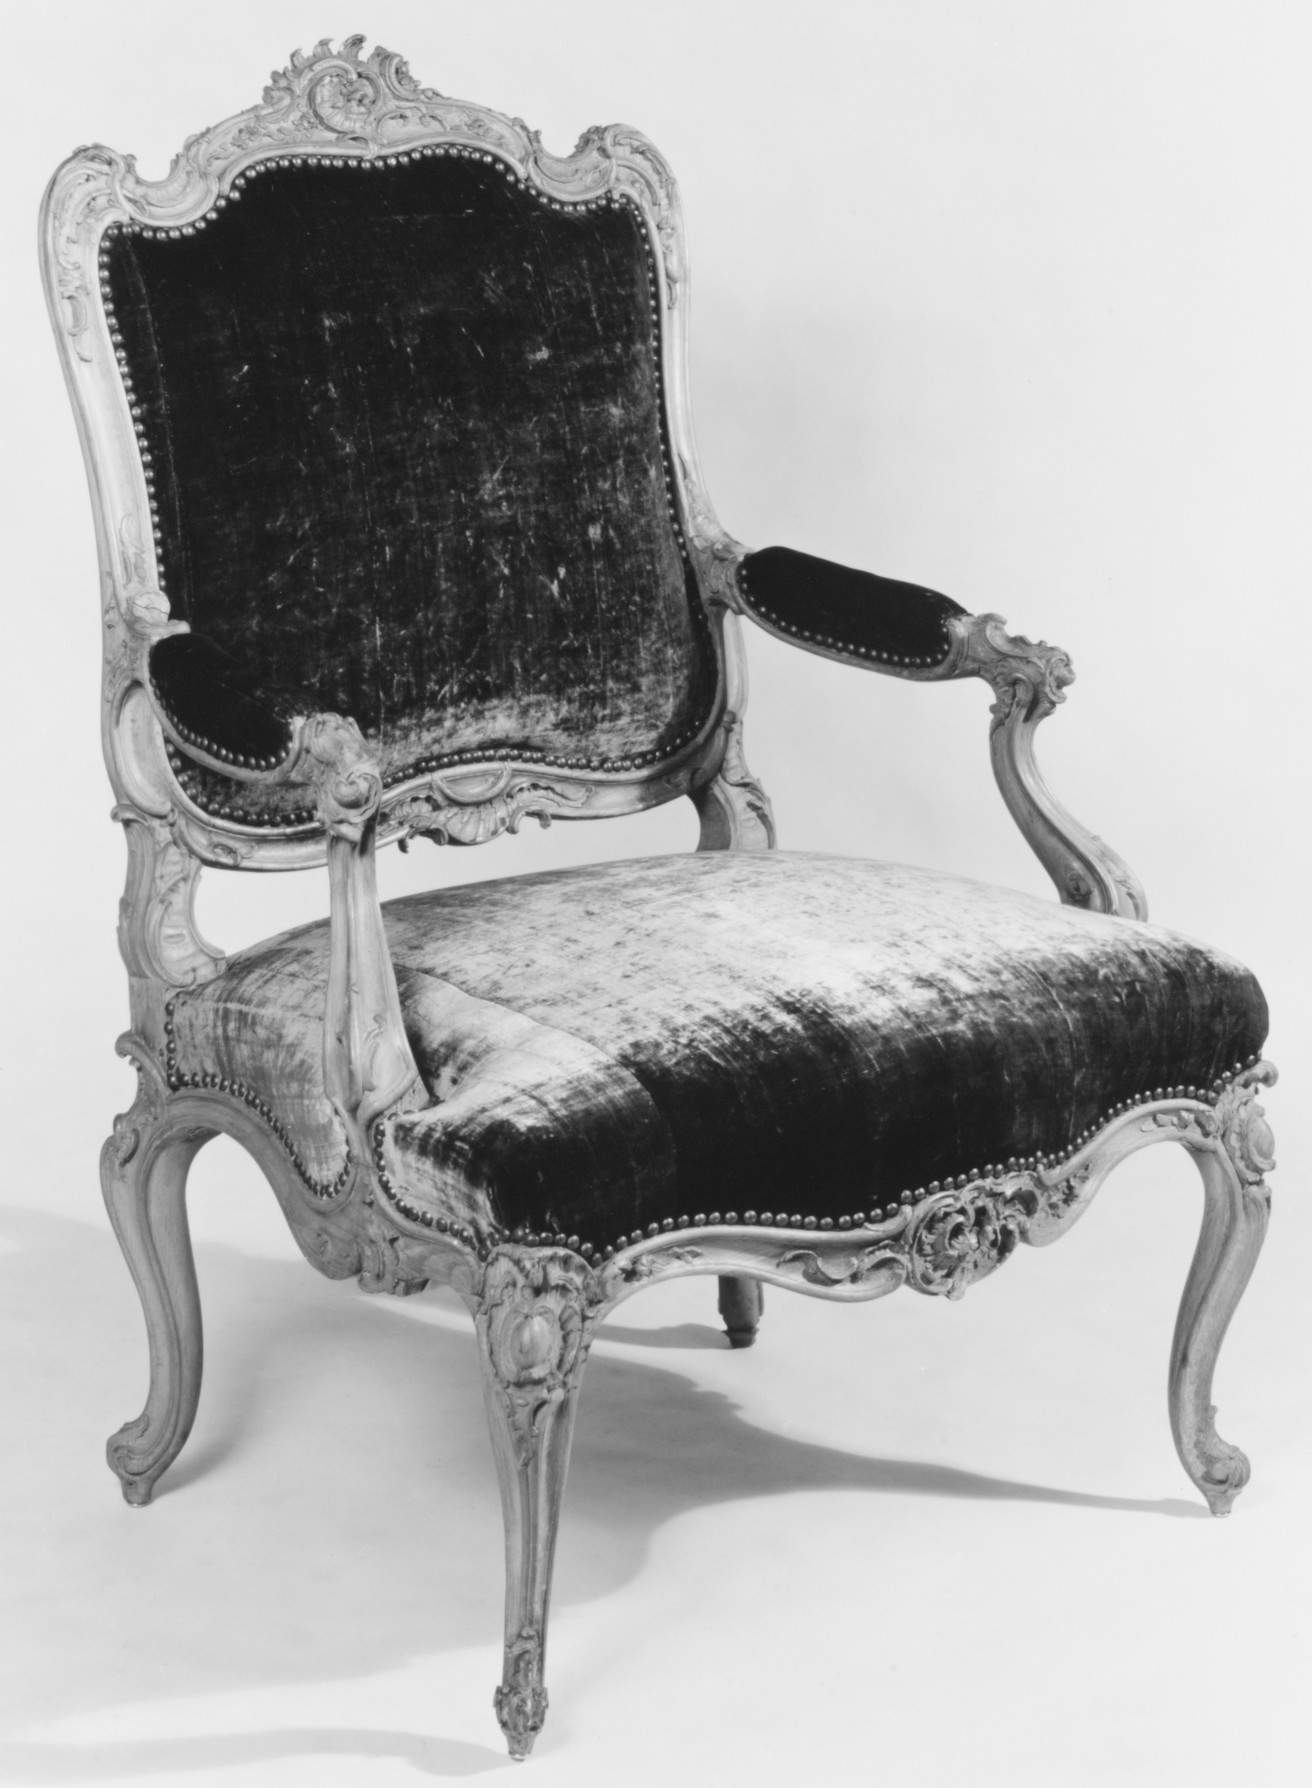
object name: armchair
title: Armchair (one of a pair)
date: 1760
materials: wood